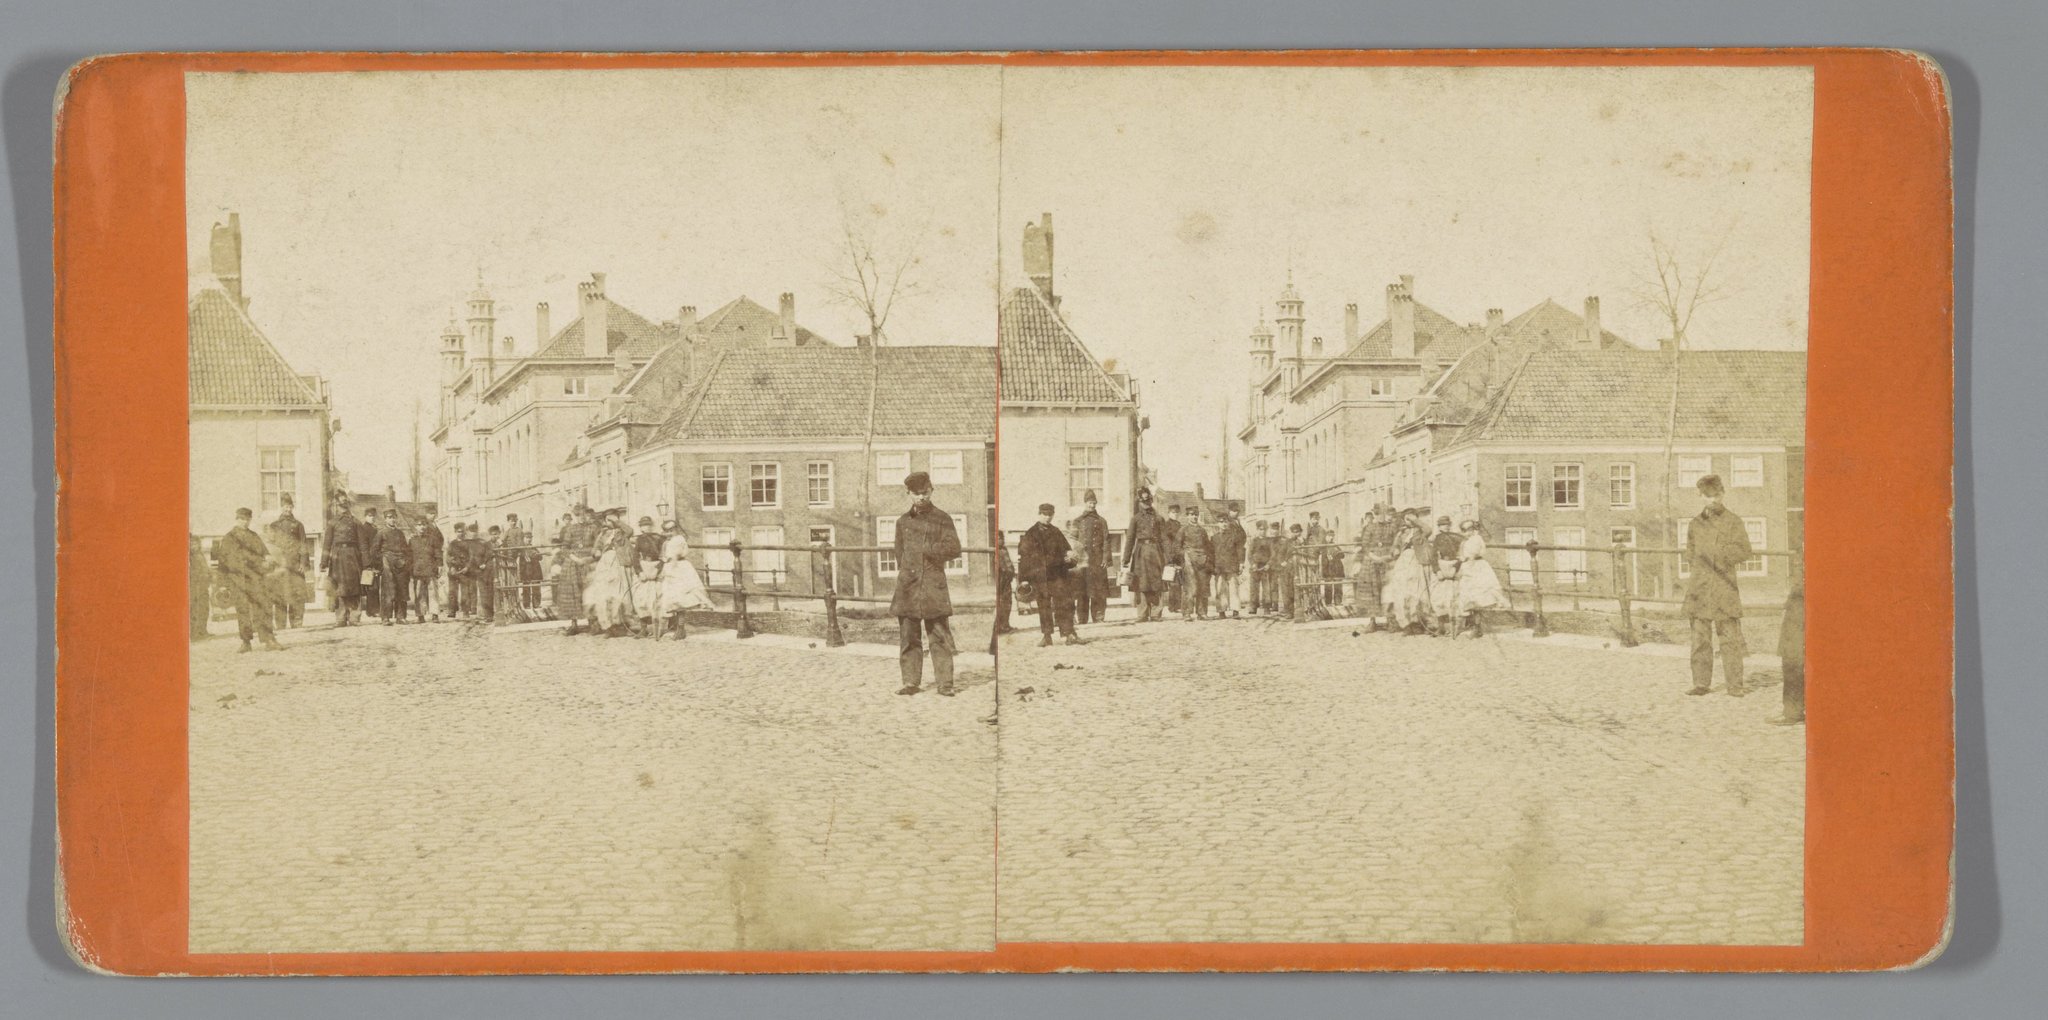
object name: stereograph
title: Stadsgezicht met mensen op een brug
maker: Anonymous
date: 1868-1890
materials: cardboard, paper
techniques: albumen print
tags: city-view in general; 'veduta'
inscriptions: number: ‘1.50’